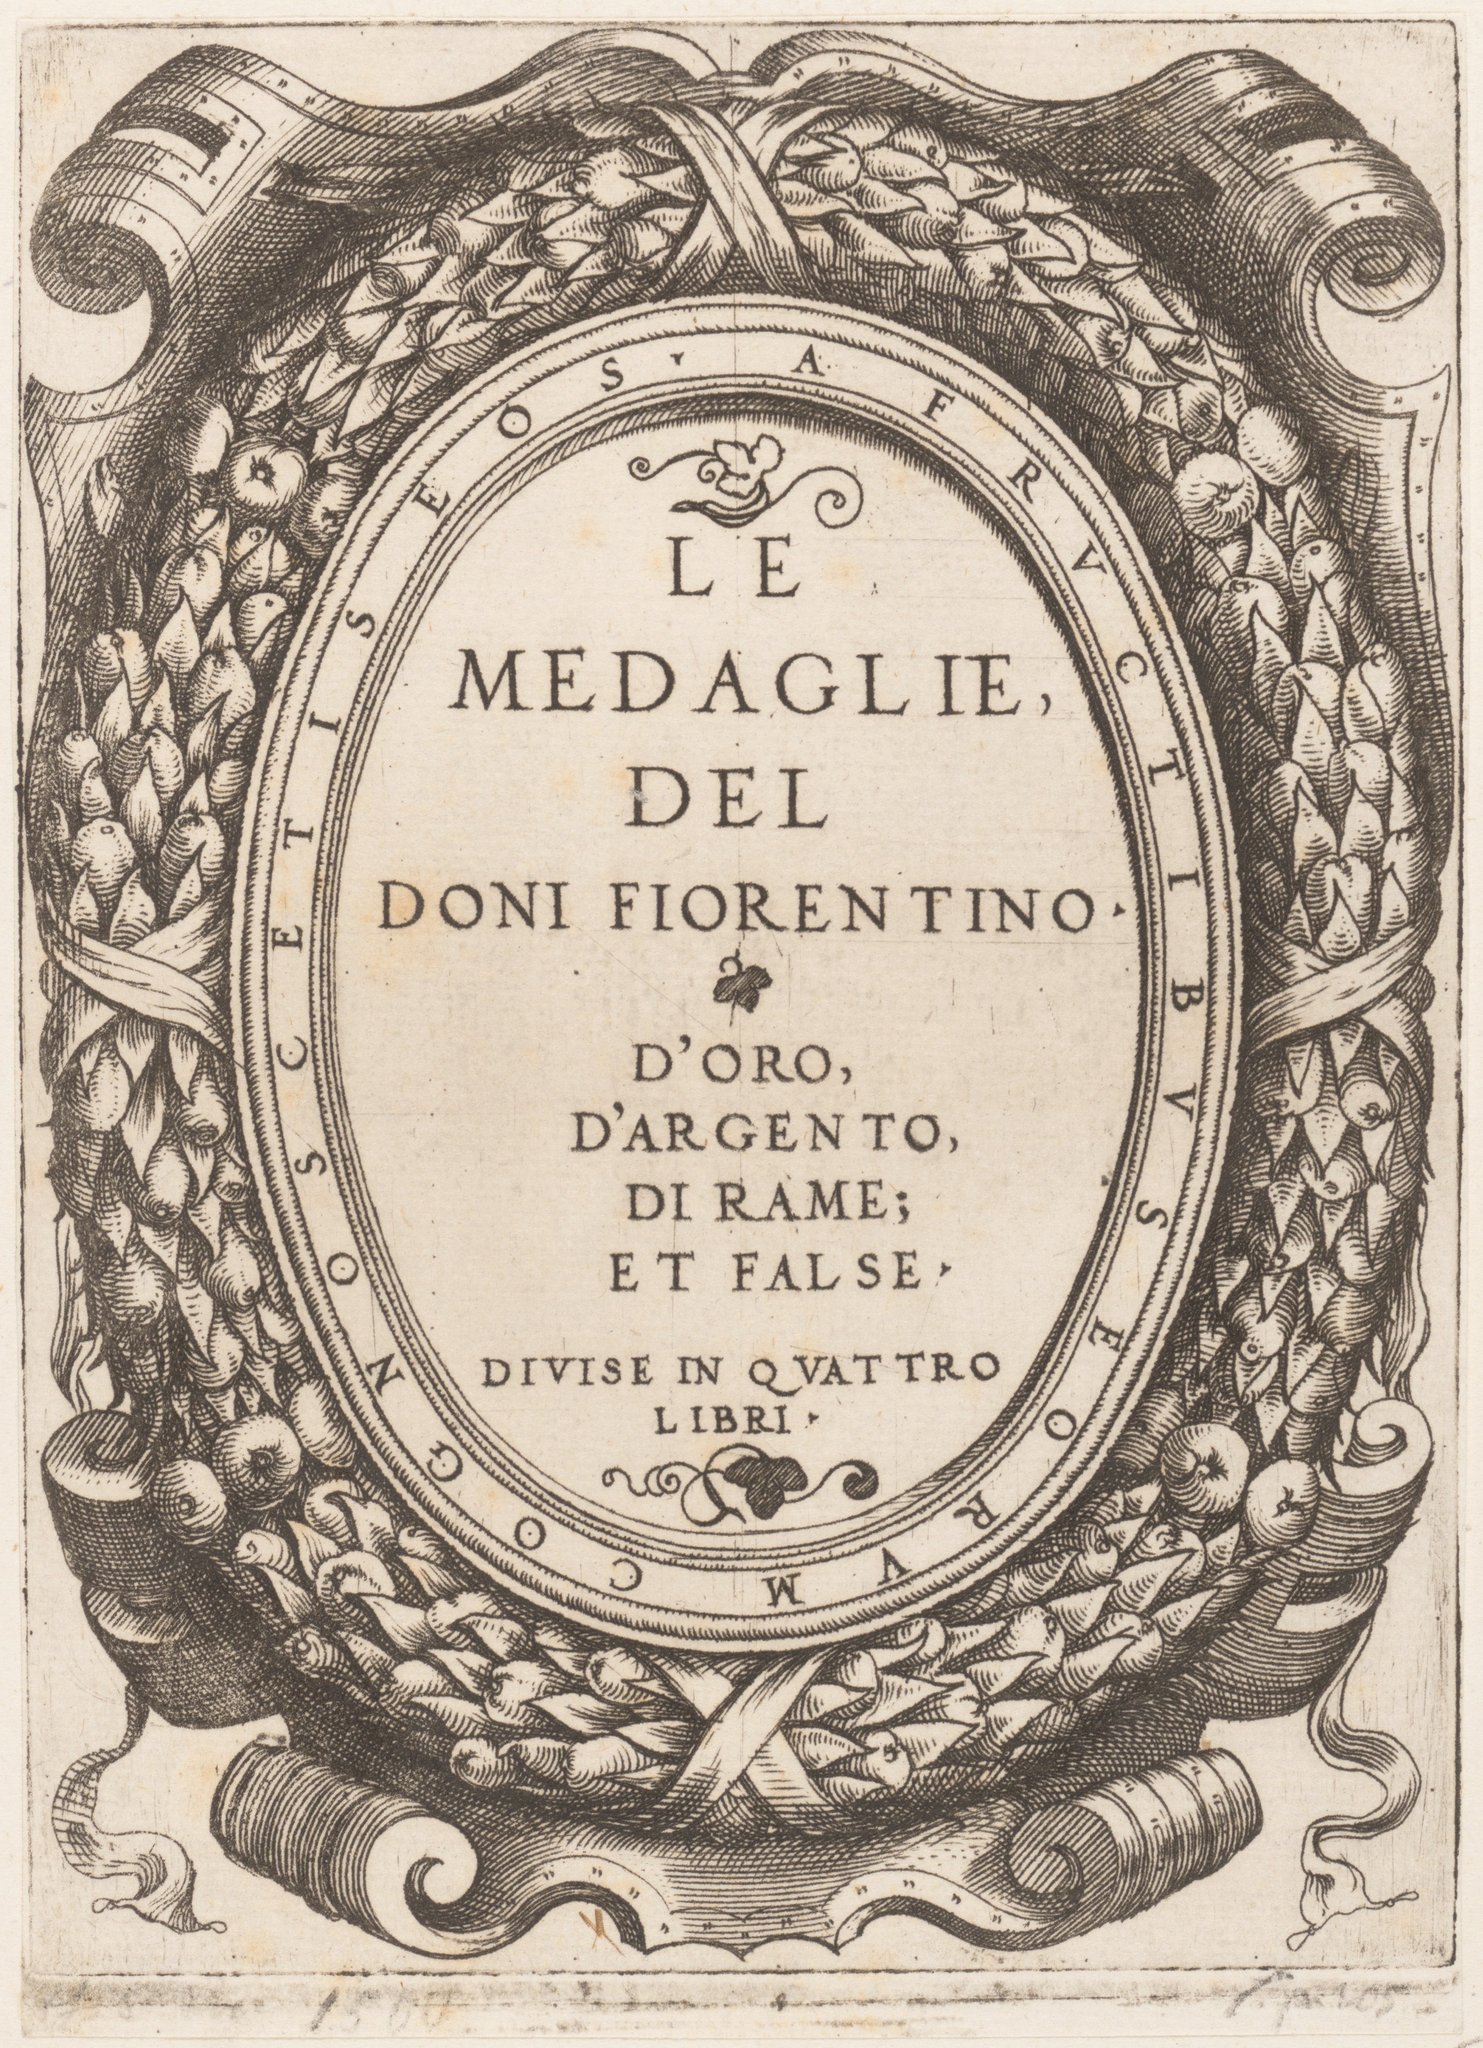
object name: print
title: Title plate: Le Medaglie del Doni Fiorentino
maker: enea vico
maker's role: artist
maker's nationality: italian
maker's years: 1523-1567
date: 1548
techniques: engraving